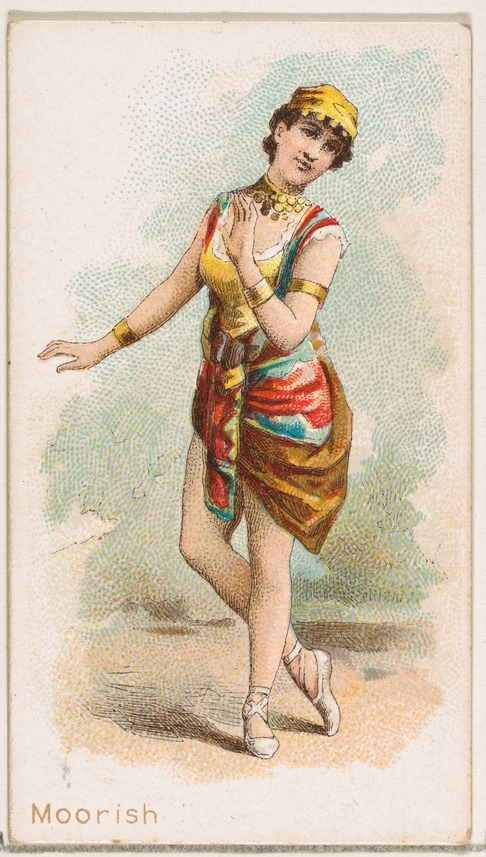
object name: print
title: Moorish Dancer, from the Dancing Women series (N186) issued by Wm. S. Kimball & Co.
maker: william s. kimball & company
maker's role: publisher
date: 1889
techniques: color lithograph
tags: women,dancers